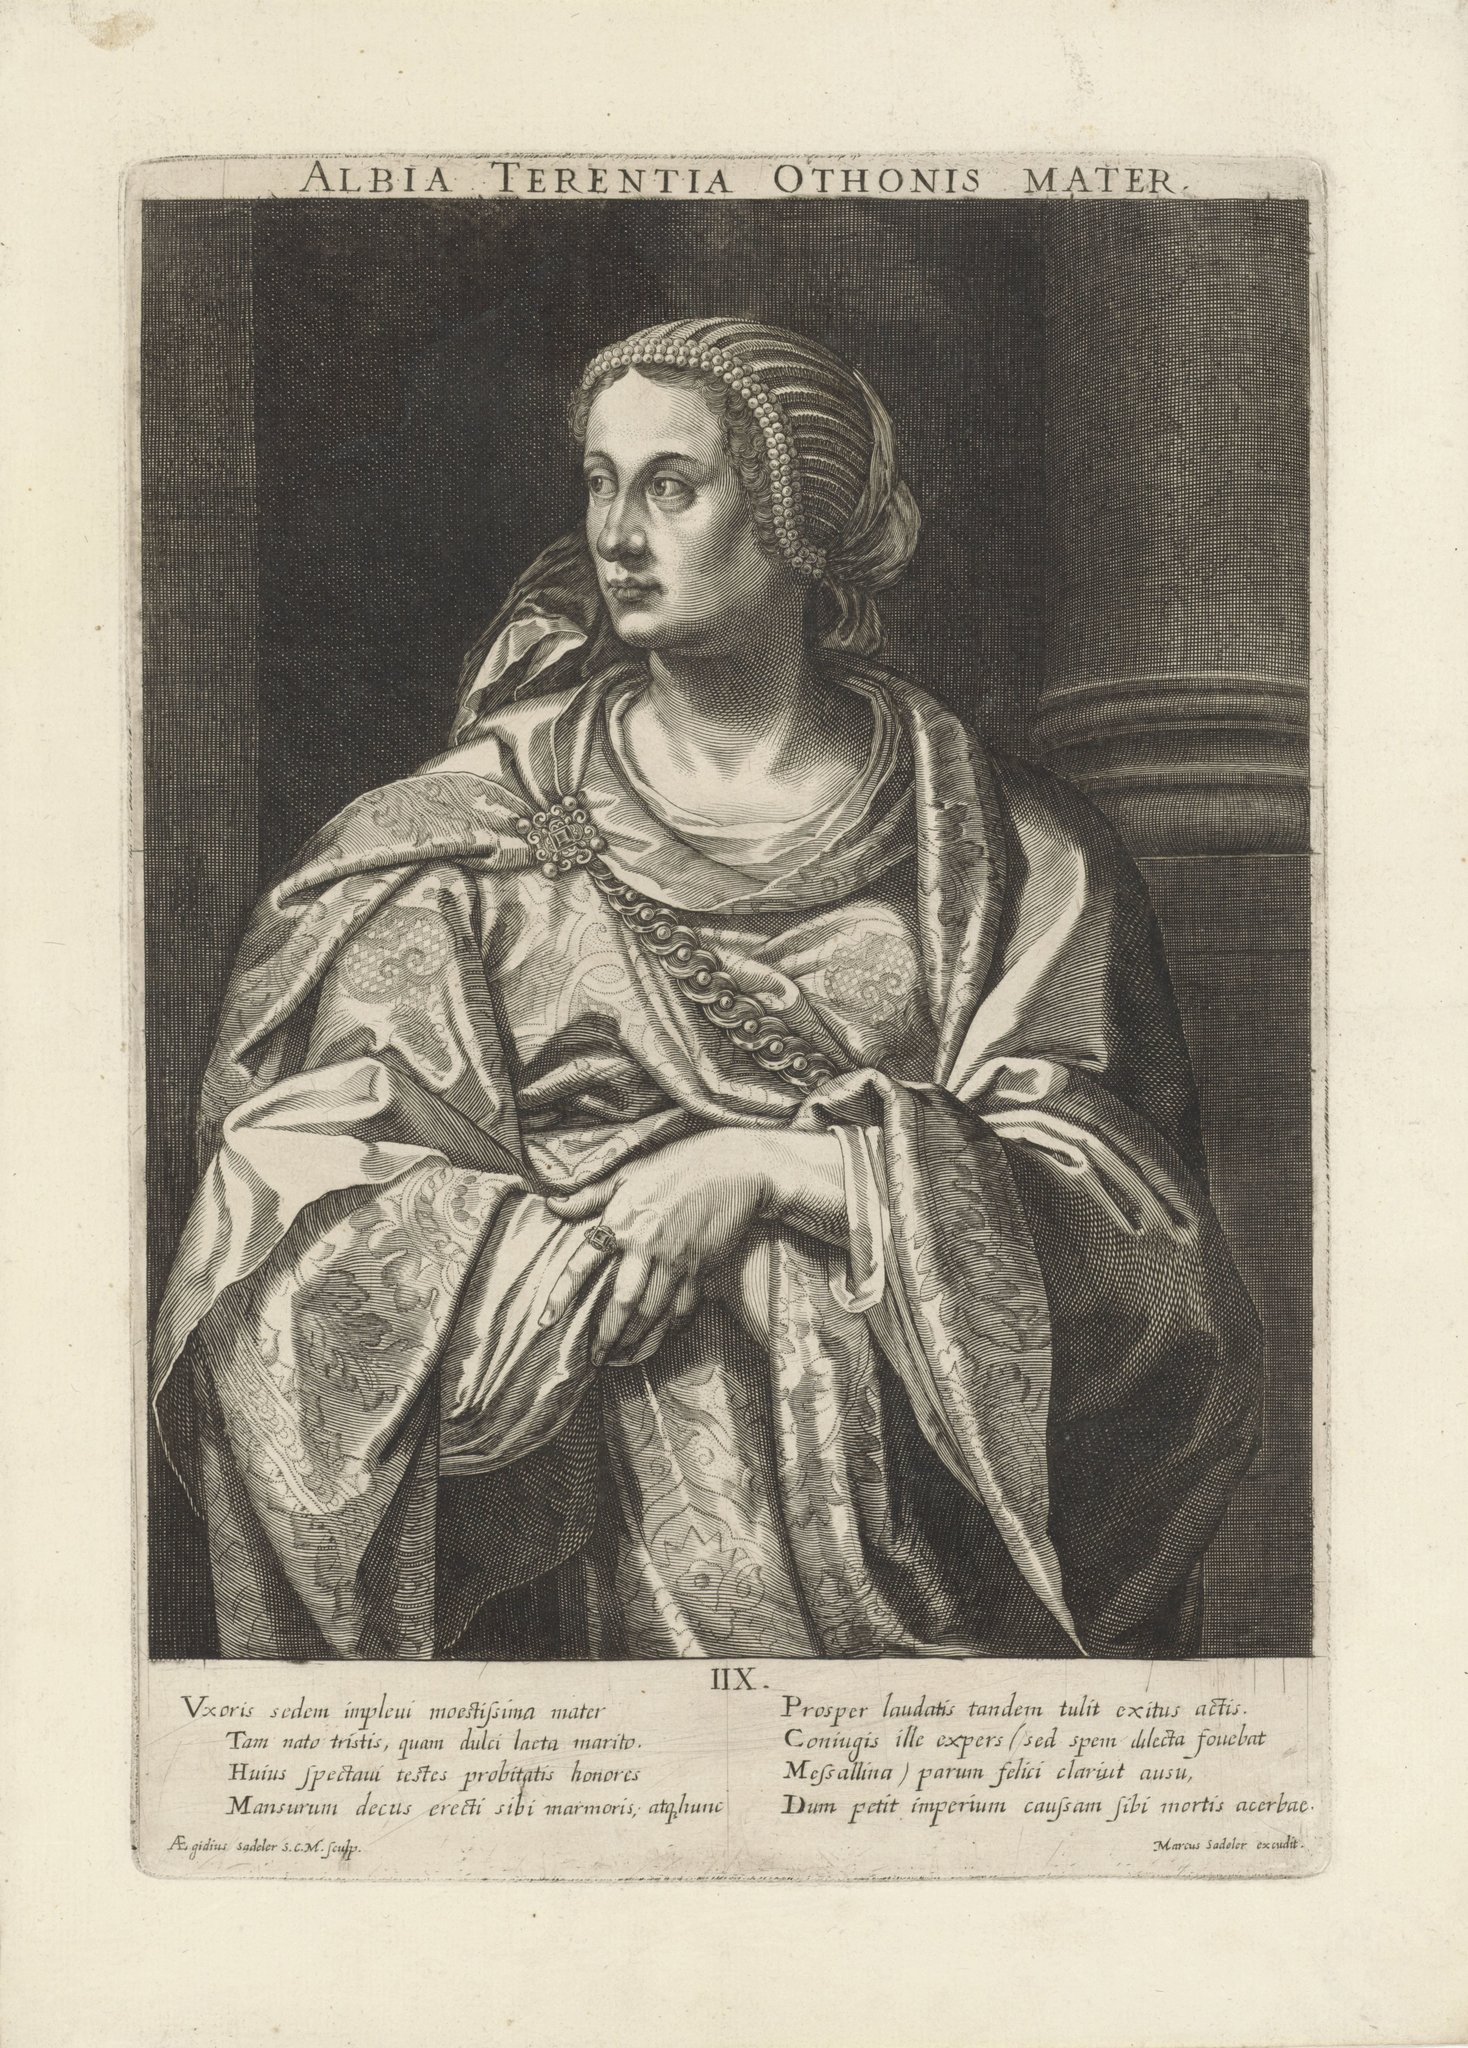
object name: print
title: Portret van Terentia Albia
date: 1597-1629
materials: paper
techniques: engraving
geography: venice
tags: terentia albia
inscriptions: collector's mark: Lugt 240